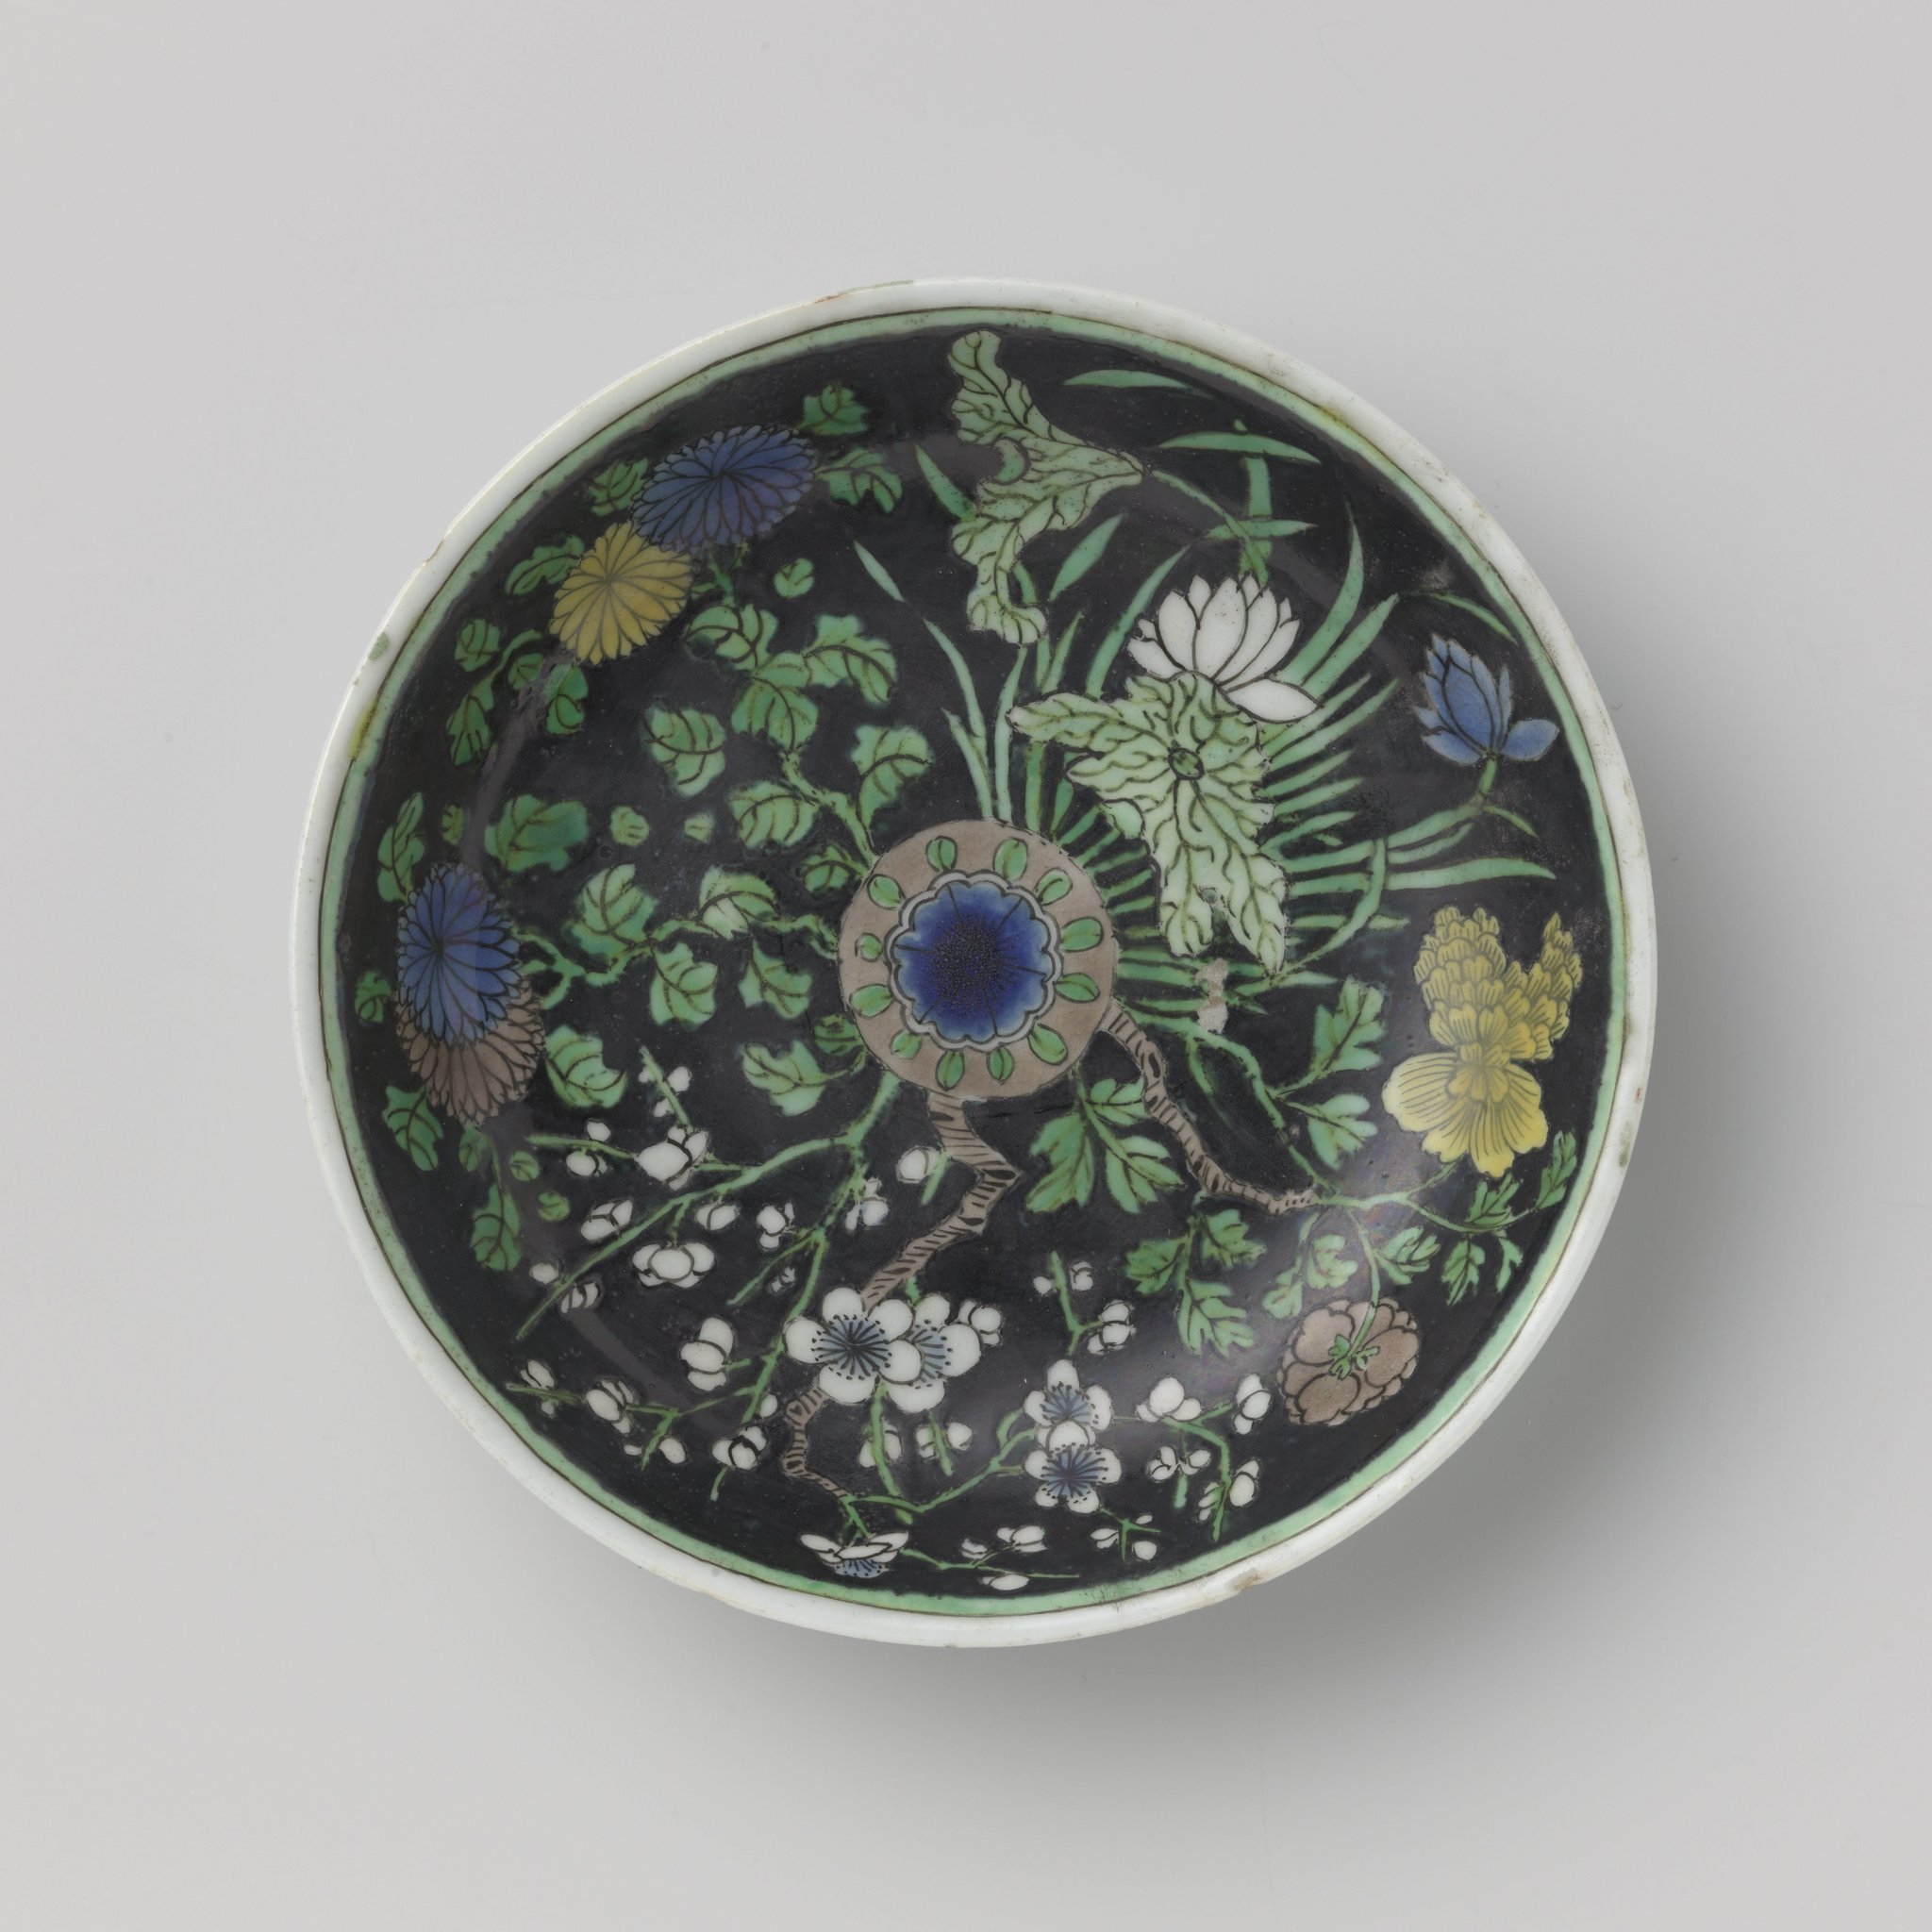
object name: platter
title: Saucer with flowering plants on a black ground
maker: Anonymous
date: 1700-1724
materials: cobalt, glaze, paint, porcelain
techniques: firing, turning, vitrification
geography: china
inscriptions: mark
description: Schotel van porselein met ronde wand, beschilderd in onderglazuur blauw, op biscuit blauw, groen, geel, aubergine en zwart en op het glazuur groen, aubergine en zwart. De voorzijde van de schotel is bedekt met een zwart glazuur met hierin uitgespaard een medaillon met daar omheen bloeiende planten in reserve (lotus, chrysant, prunus en pioen); de onderzijde met vier bloemtakken, het aubergine email van de bloem afgeschraapt. Gemerkt op de onderzijde in onderglazuur blauw met een artemisiablad in een dubbele cirkel. Drie chips in de rand. Mogelijk in Europa gedecoreerd. Email sur biscuit met famille noire kleuren.